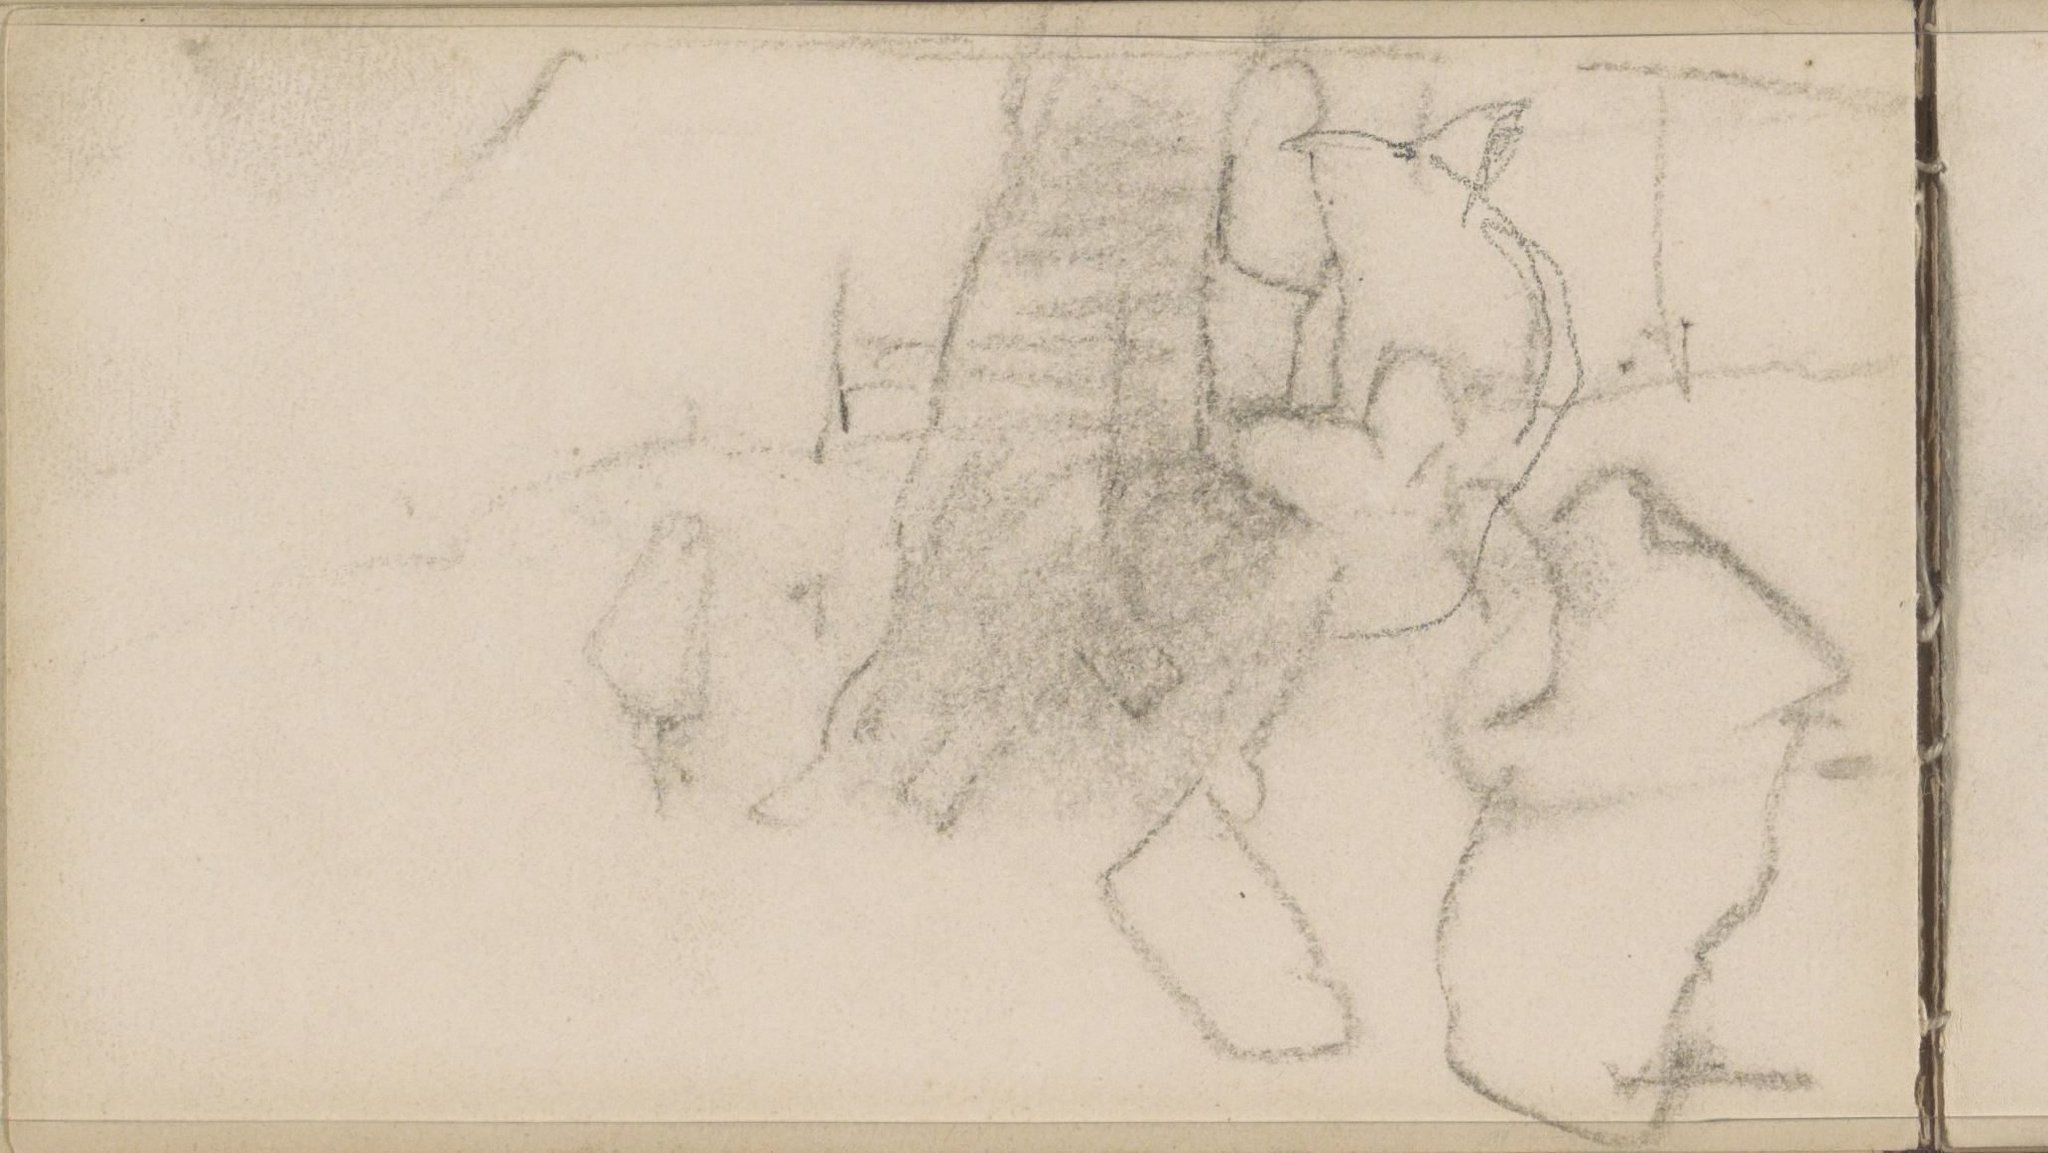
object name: sketchbook leaf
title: Figuurstudies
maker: george hendrik breitner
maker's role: draughtsman, painter, print maker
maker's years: 1857-1923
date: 1880-1882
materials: chalk, paper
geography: the hague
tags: adult woman, adult man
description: Blad 18 verso uit een schetsboek met 16 bladen.